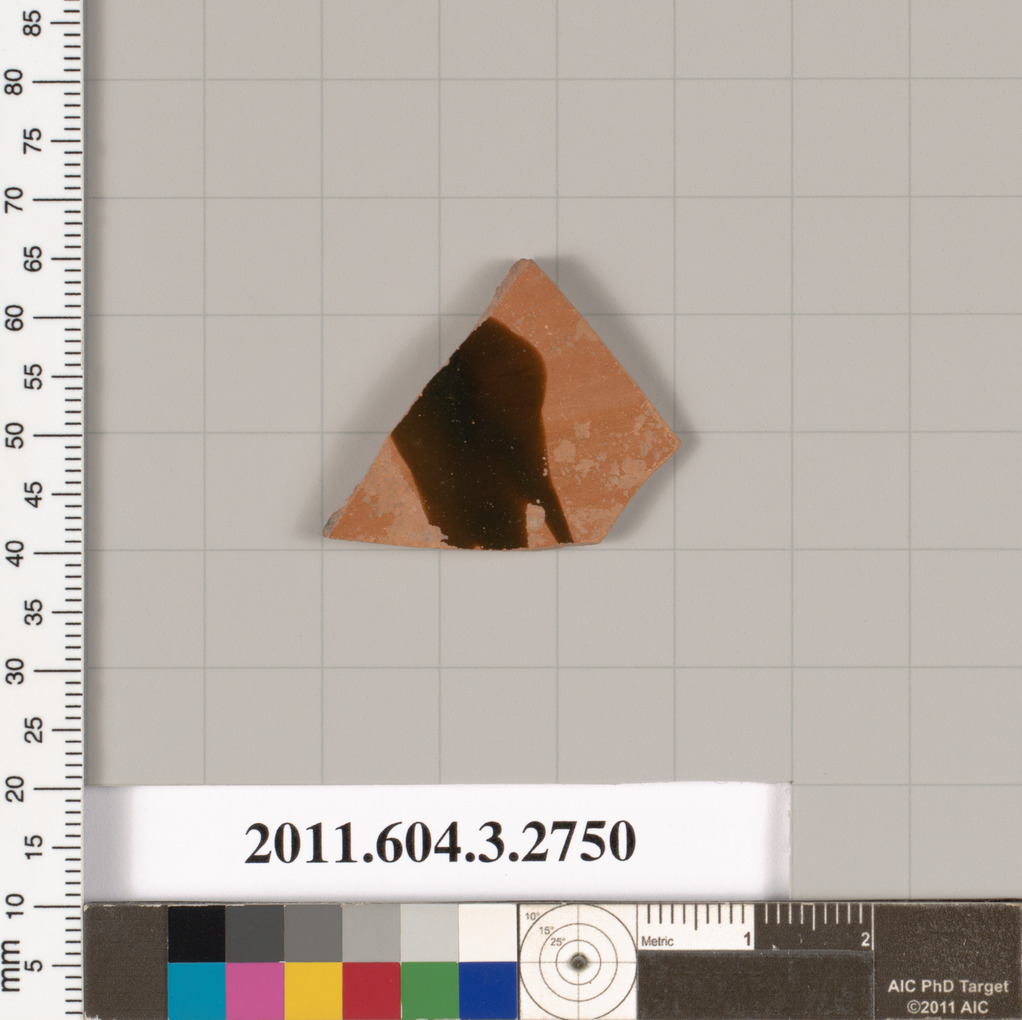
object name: olpe fragment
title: Terracotta fragment of an olpe (jug)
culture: greek, attic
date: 575-551 BCE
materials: terracotta